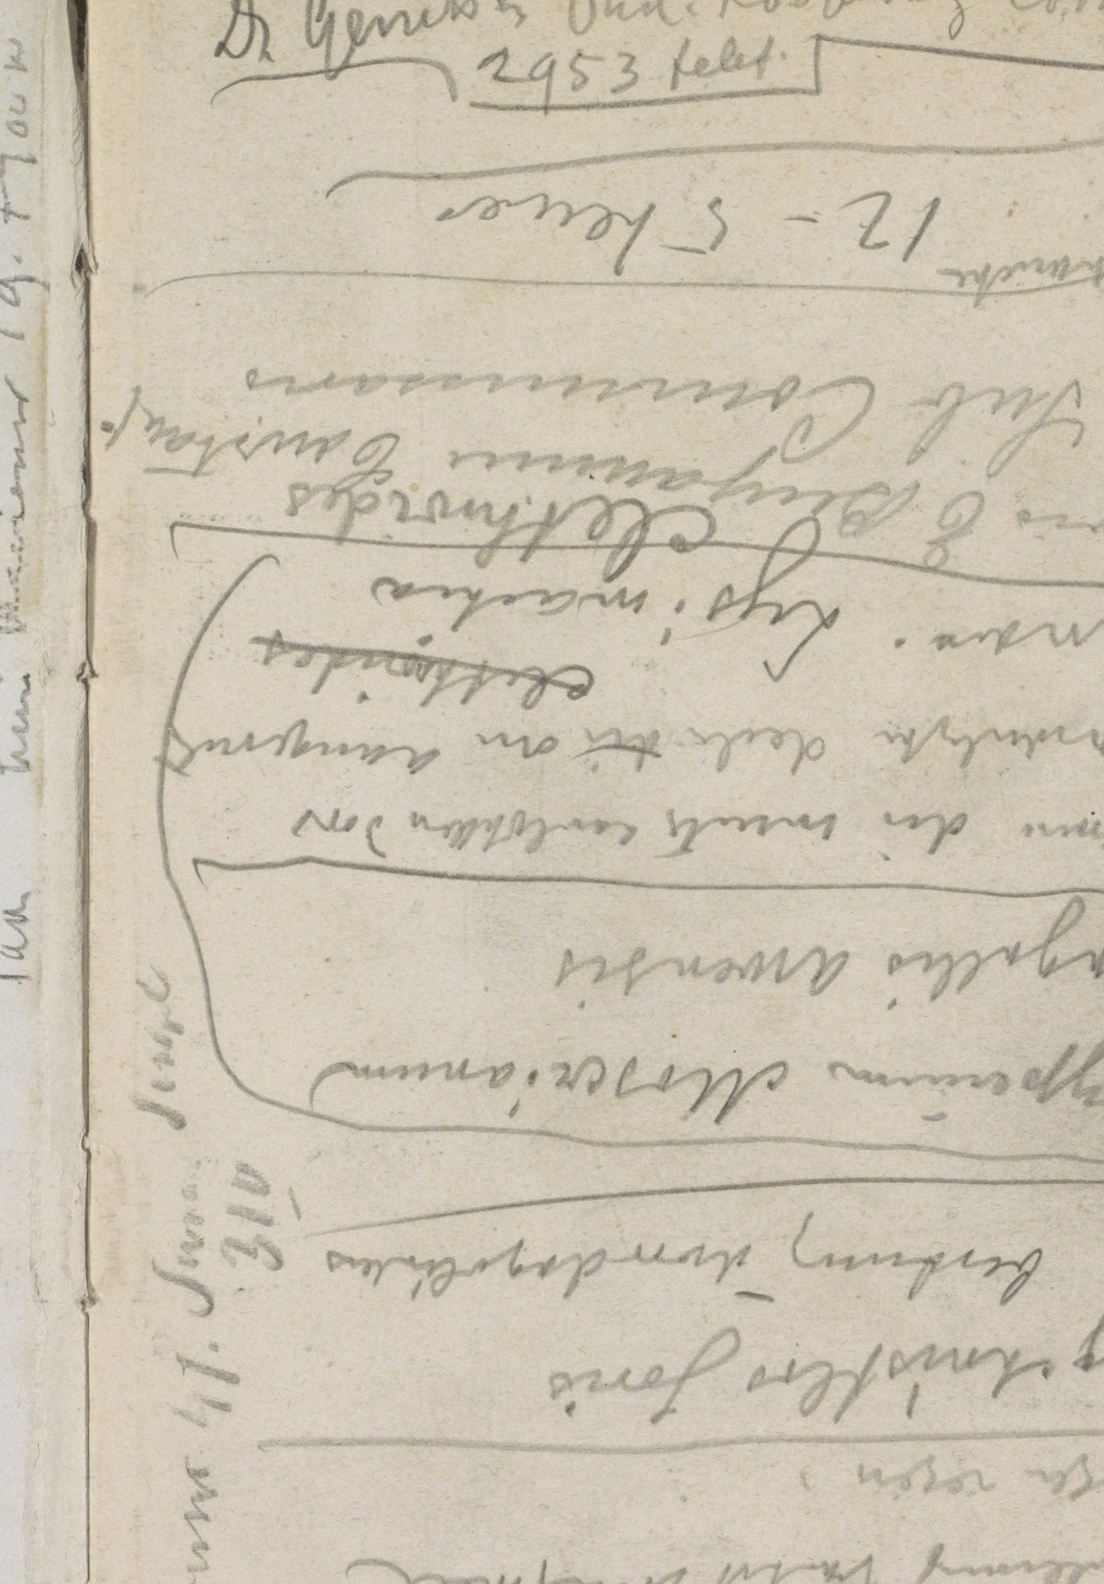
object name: sketchbook leaf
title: Annotaties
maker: george hendrik breitner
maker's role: draughtsman, painter, print maker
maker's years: 1857-1923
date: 1886-1903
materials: paper, pencil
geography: amsterdam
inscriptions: annotation: ‘Cerinthe major L.D/ Bescherming van het stuifmeel/ tegen regen/ Lychnisflos Joris/ bestu[...] door dagvlinders/ Hyperium Moscrianum/ Anagallis Arvensis/ Bloemen die insecten aanlokken door/ afzonderlijk deels om aangevreten / te worden. Lysimachia/ Navis & Benjamin [...]/ Sub Commissaris/ Dimanche/ 12-5 heures’, annotation: ‘Dr. Gerritsen Oud. Roozenburg Loosduinen/ 2953 telef.’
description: Pagina 2 uit een schetsboek met 46 bladen.